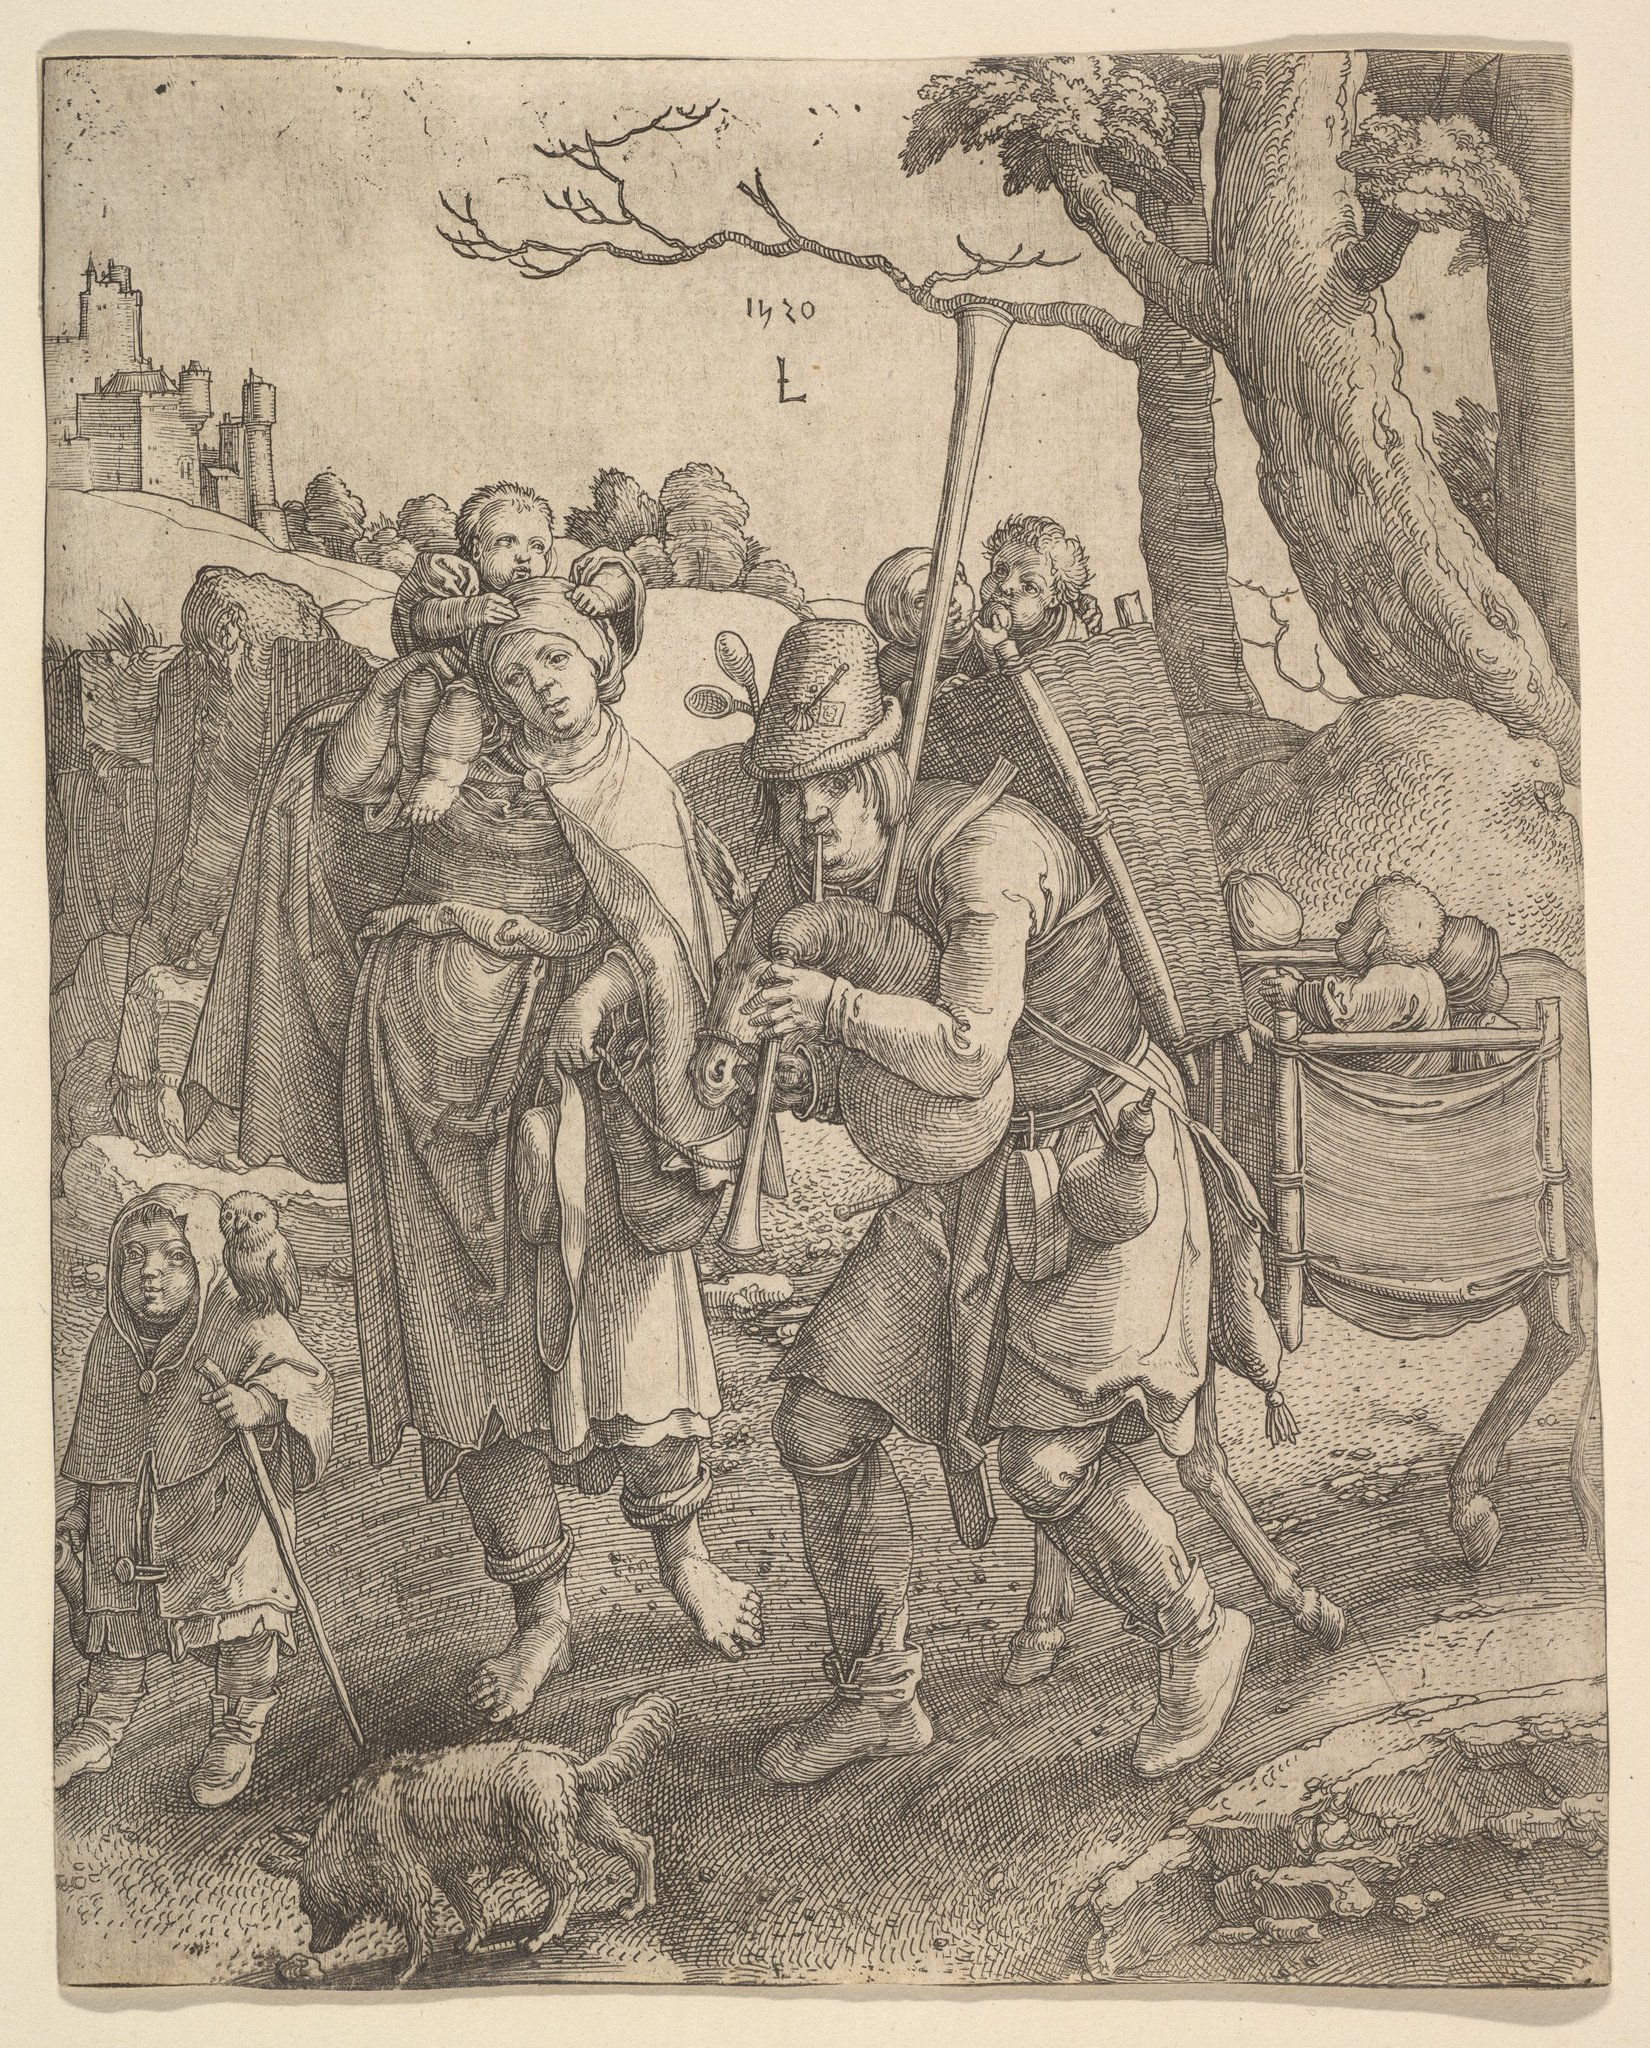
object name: print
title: The Beggars (Eulenspiegel)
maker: lucas van leyden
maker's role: artist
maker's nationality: netherlandish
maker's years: 1494-1533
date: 1520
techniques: engraving, etching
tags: children,men,women,bagpipes,owls,dogs,donkeys